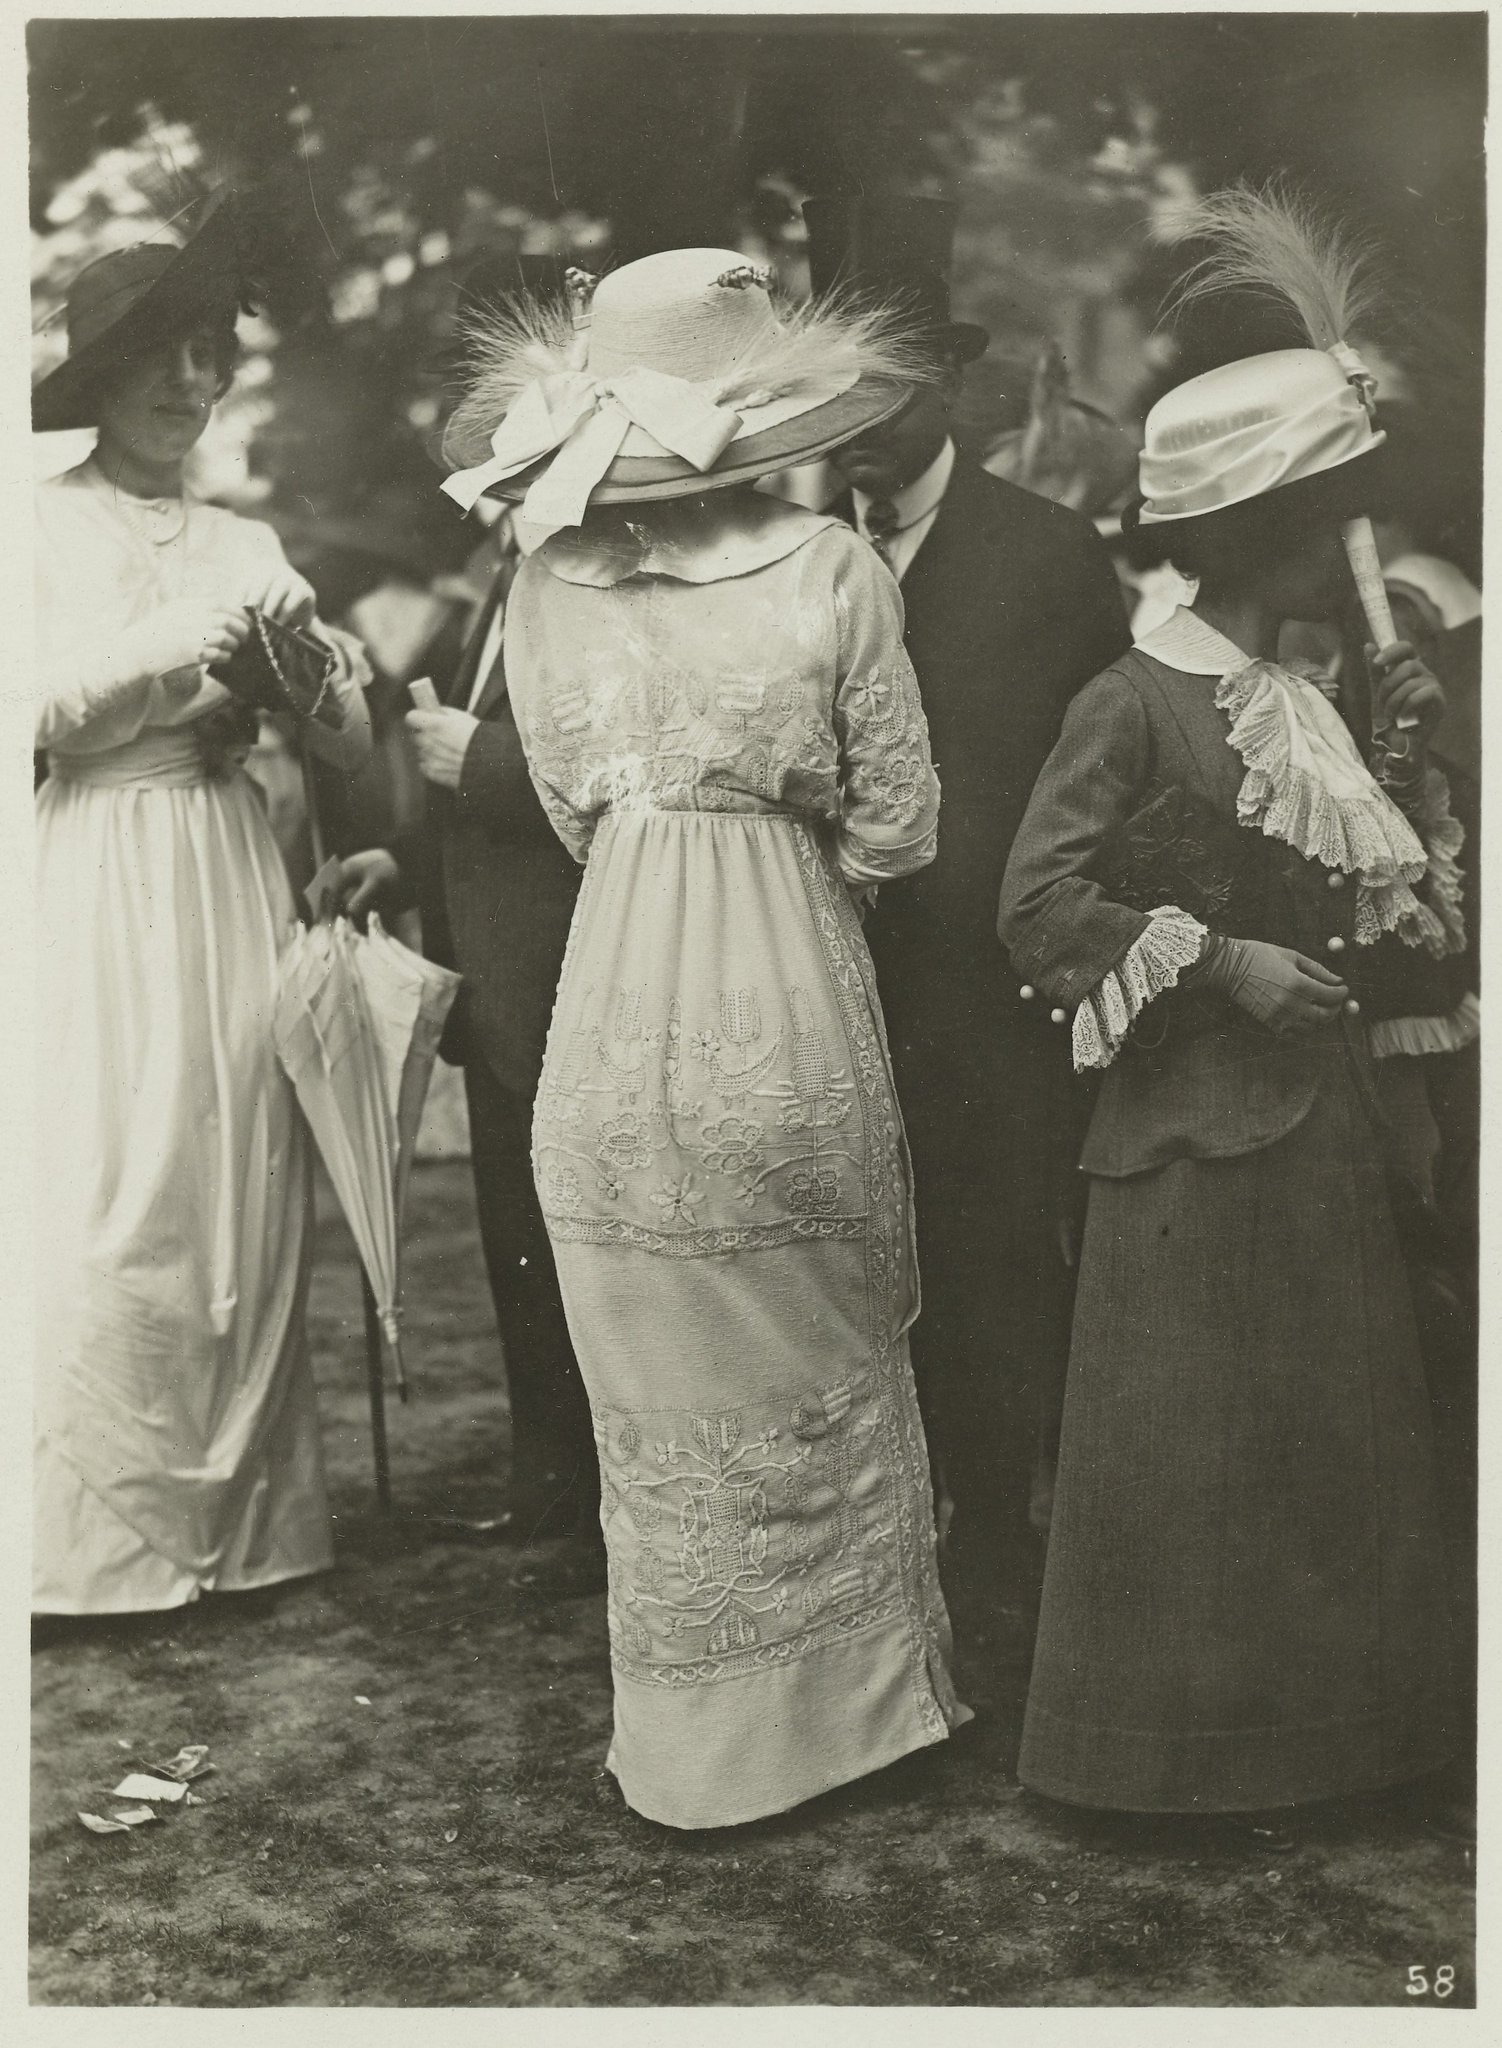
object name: photograph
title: Drie dames bij de Hippodrome de Longchamp tijdens paardenraces in het Bois de Boulogne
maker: a. calavas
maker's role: publisher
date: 1912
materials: paper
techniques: gelatin silver print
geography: paris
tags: fashionable woman, 'belle'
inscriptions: number: ‘58’, copyright notice: ‘déposé/ copyright’